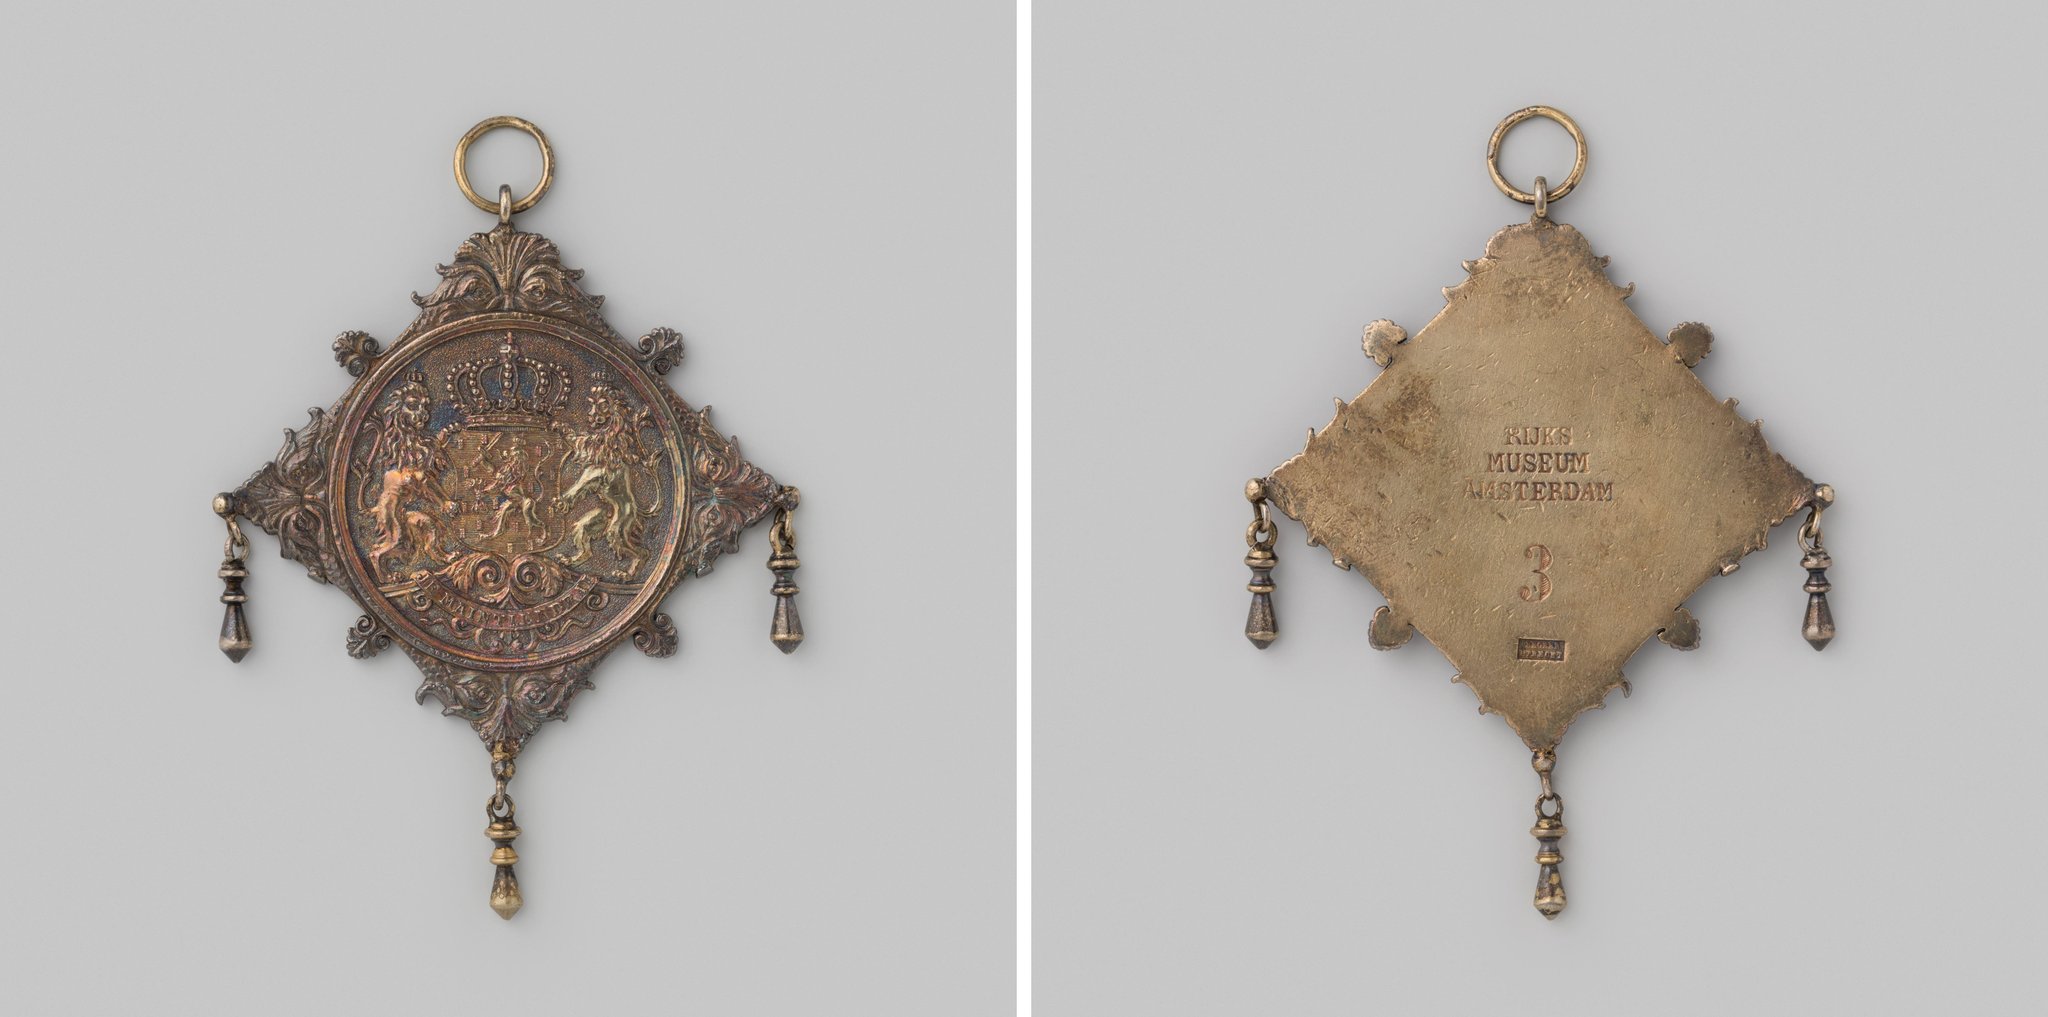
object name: insignia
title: Insigne voor zaalwachters, nr. 3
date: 1889-1890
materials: silver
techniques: gilding, striking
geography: utrecht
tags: rijksmuseum amsterdam, amsterdam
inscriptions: inscription: ‘JE MAINTIENDRAI’, mark: ‘BEGEER UTRECHT’, inscription: ‘RIJKSMUSEUM AMSTERDAM 3’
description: Zilveren, ruitvormige, vergulde insigne voor de zaalwachter van het Rijksmuseum Amsterdam aan een draagring. Drie hoeken voorzien van een hangertje. Voorzijde: het wapen van Nederland (gekroond wapenschild geflankeerd door twee klimmende leeuwen) waaronder opschrift. Keerzijde: opschrift en nummer.